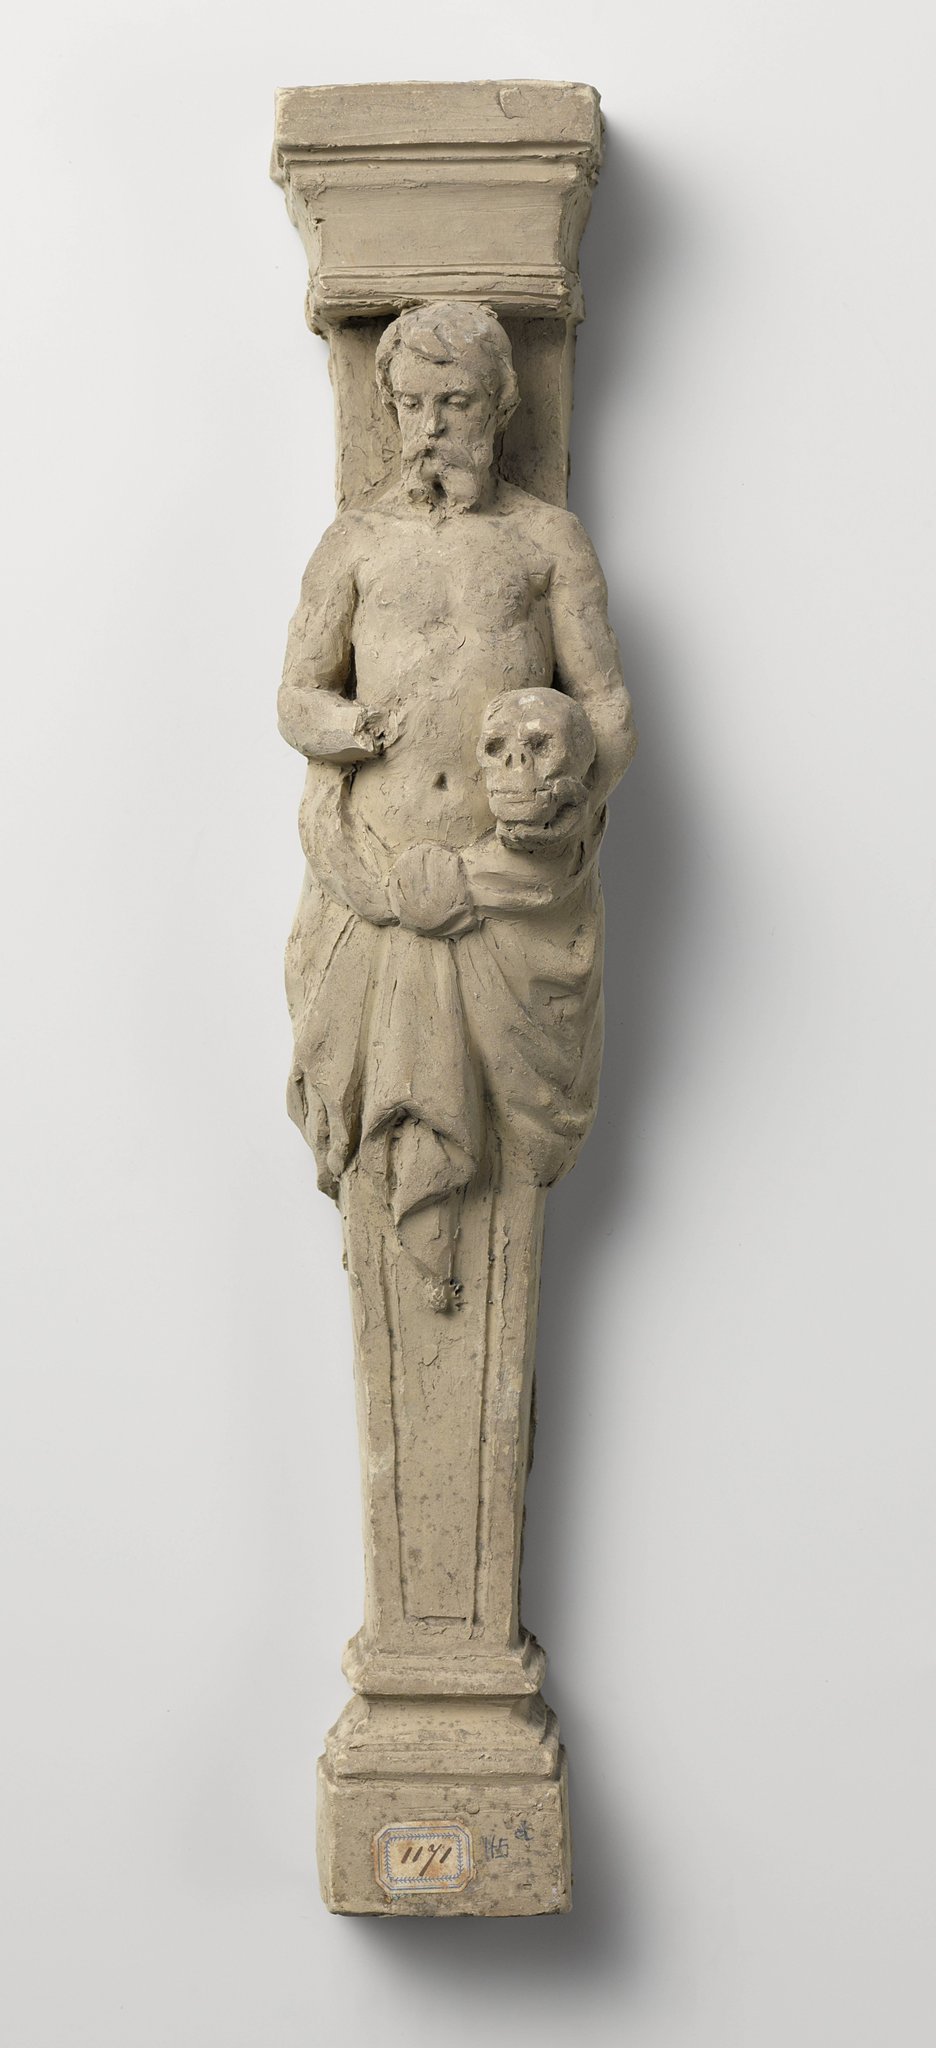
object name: sculpture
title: Karyatide: De Medische Wetenschap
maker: eugène lacomblé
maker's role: draughtsman, painter, sculptor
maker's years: 1828-1905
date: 1828-1905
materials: clay